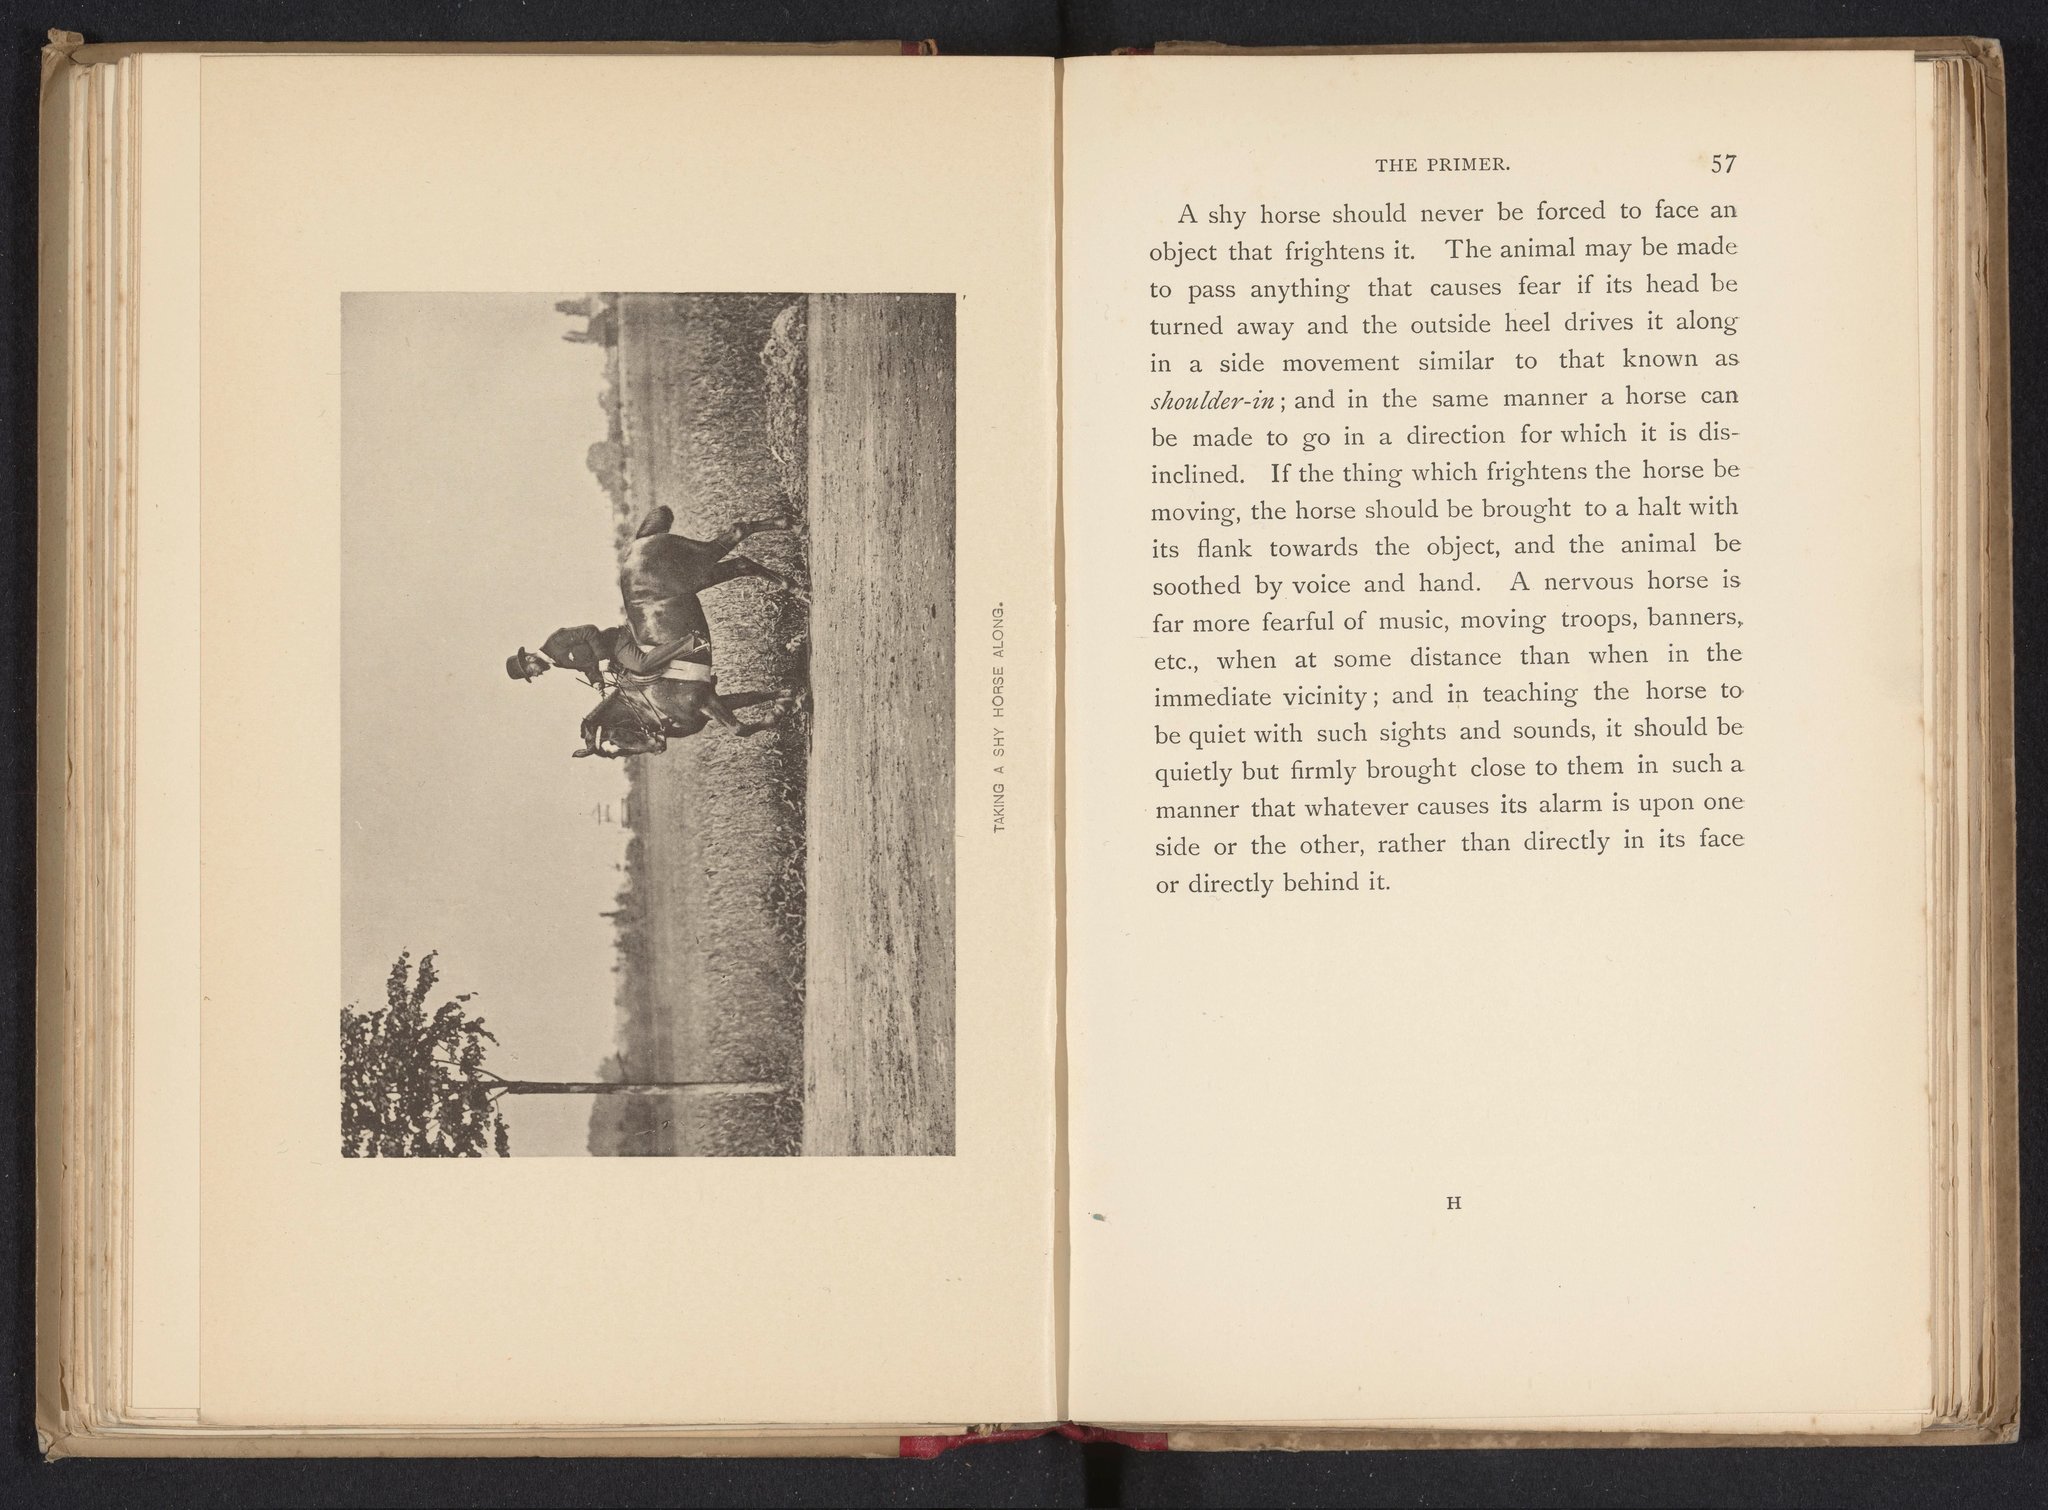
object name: photomechanical print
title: Man die op een verlegen paard rijdt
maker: Anonymous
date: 1879-1889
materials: paper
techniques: photograph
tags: riding a horse, ass, or mule; rider, horseman, head-gear: bowler hat, horse